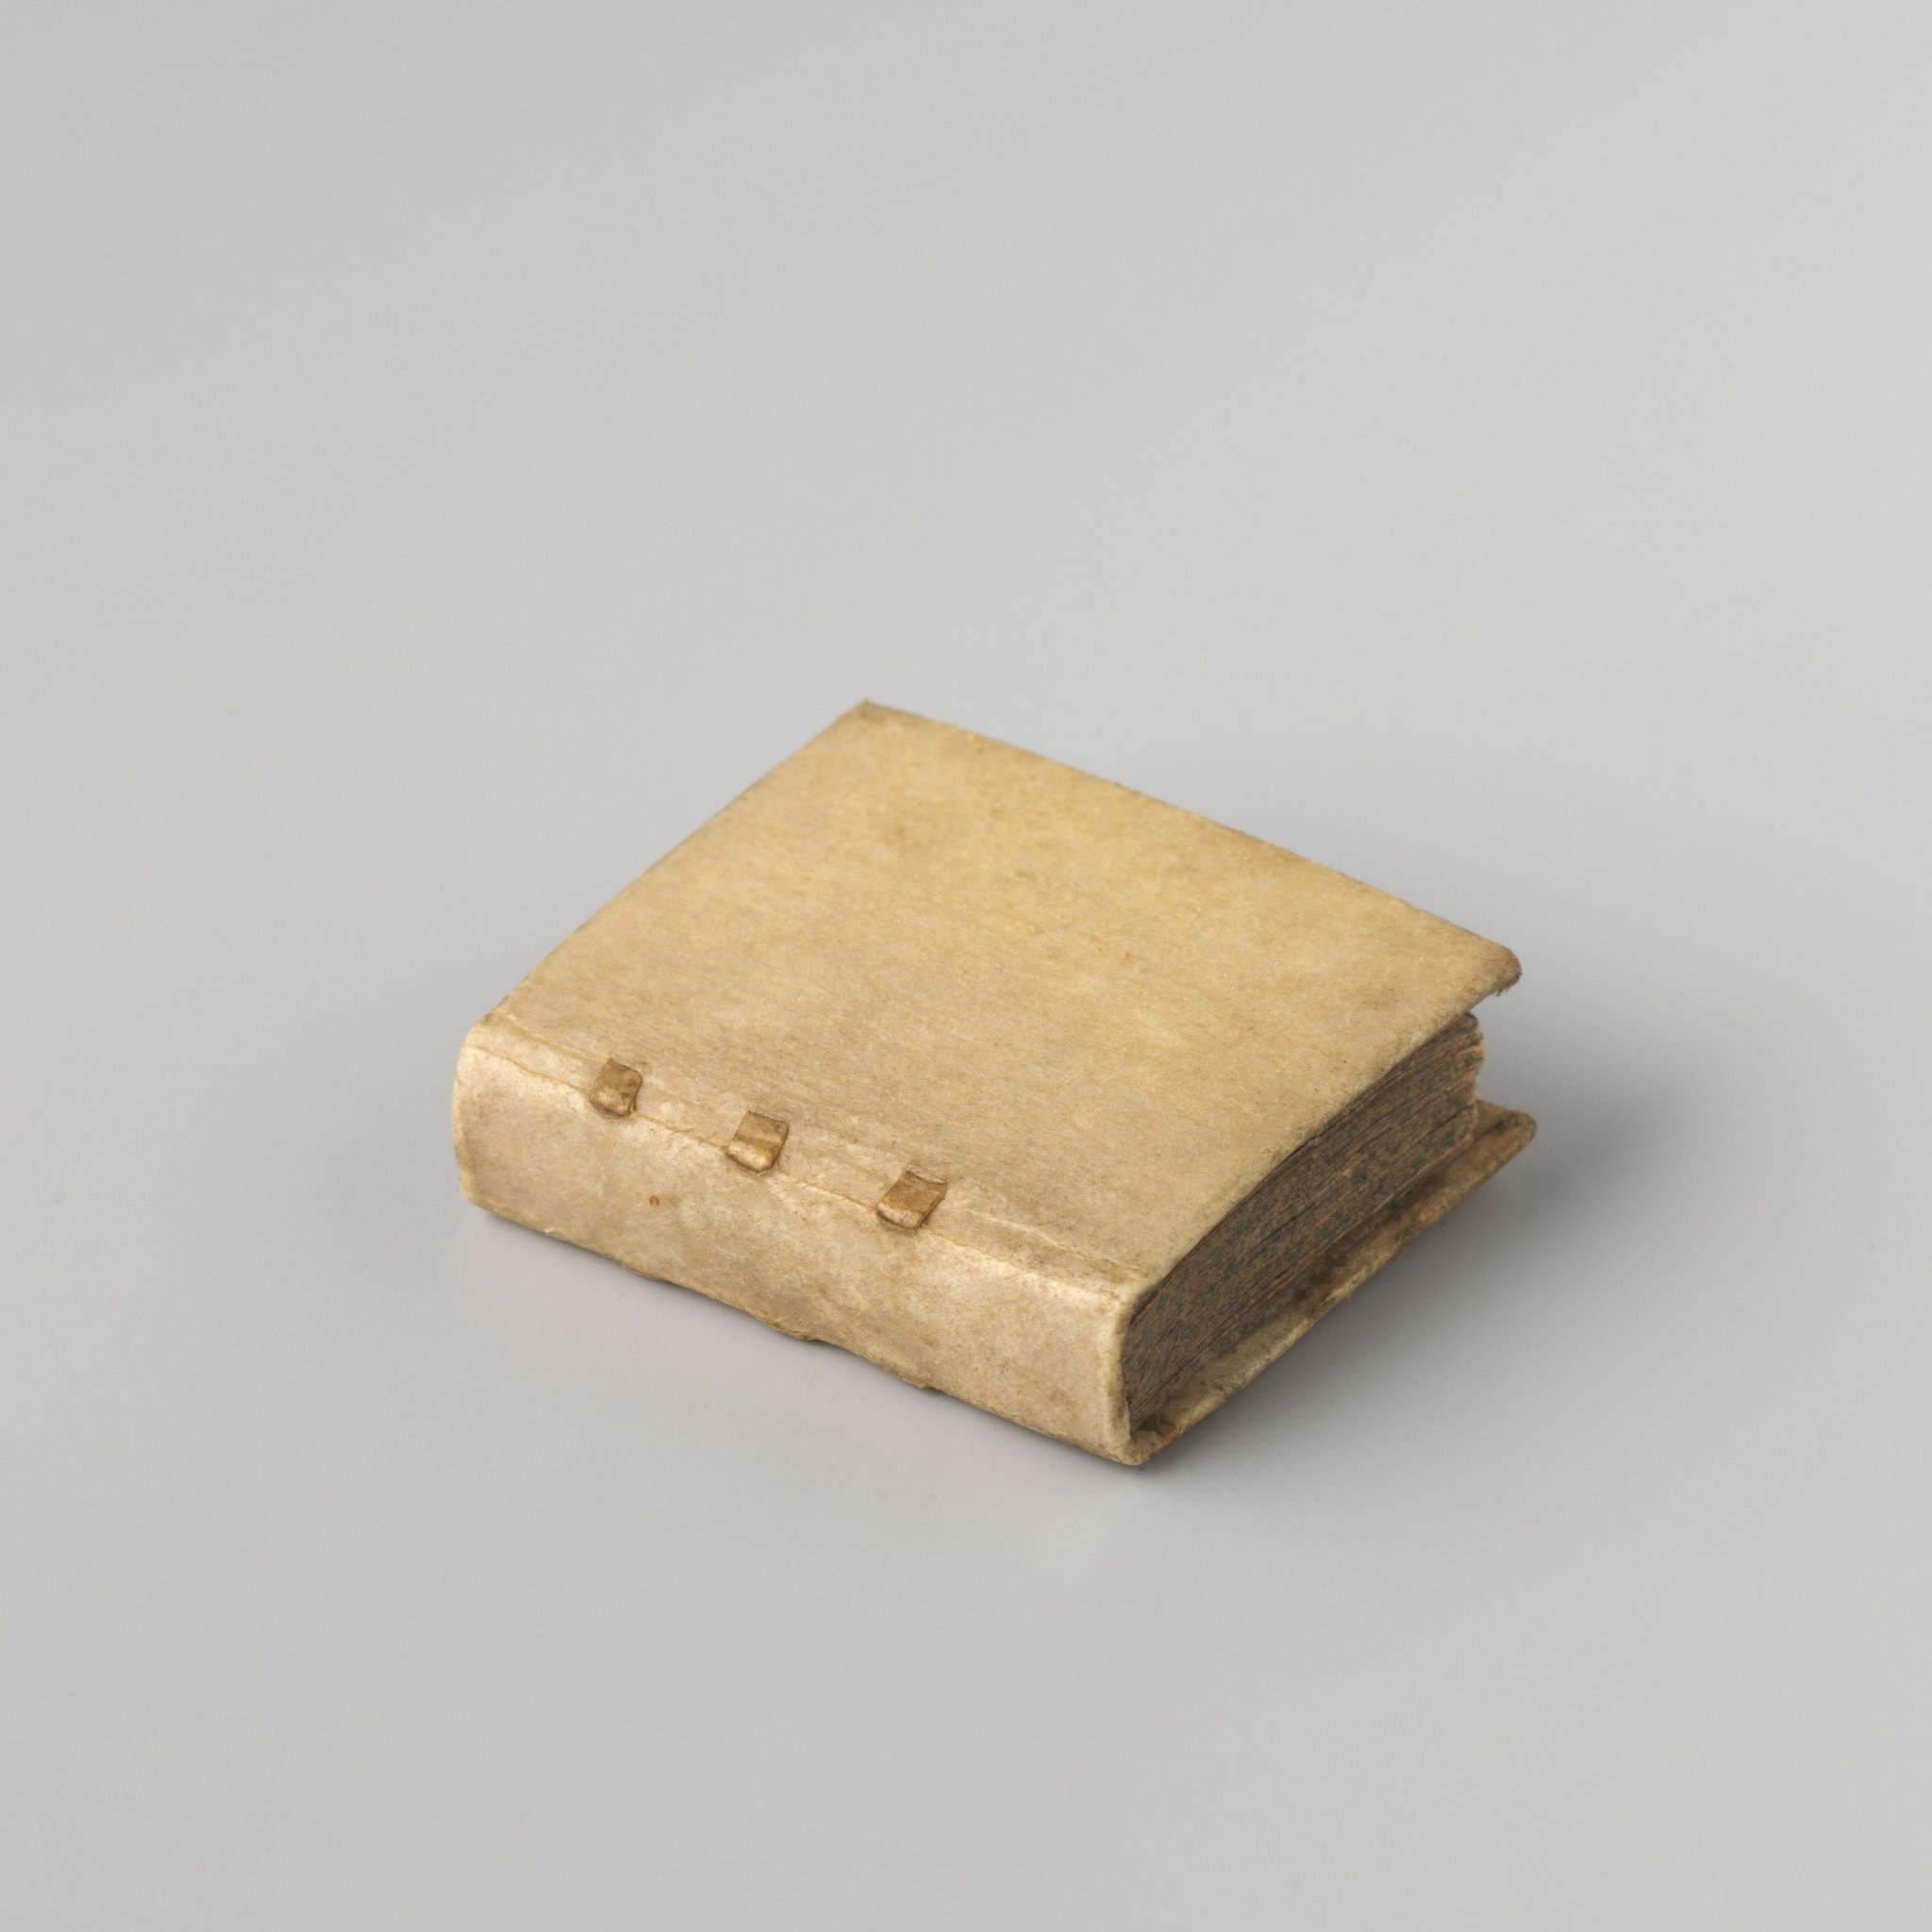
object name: book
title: Boek met figuren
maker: Anonymous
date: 1690-1710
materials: paper, parchment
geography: amsterdam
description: Boek met figuren. Ingebonden in blank perkament.